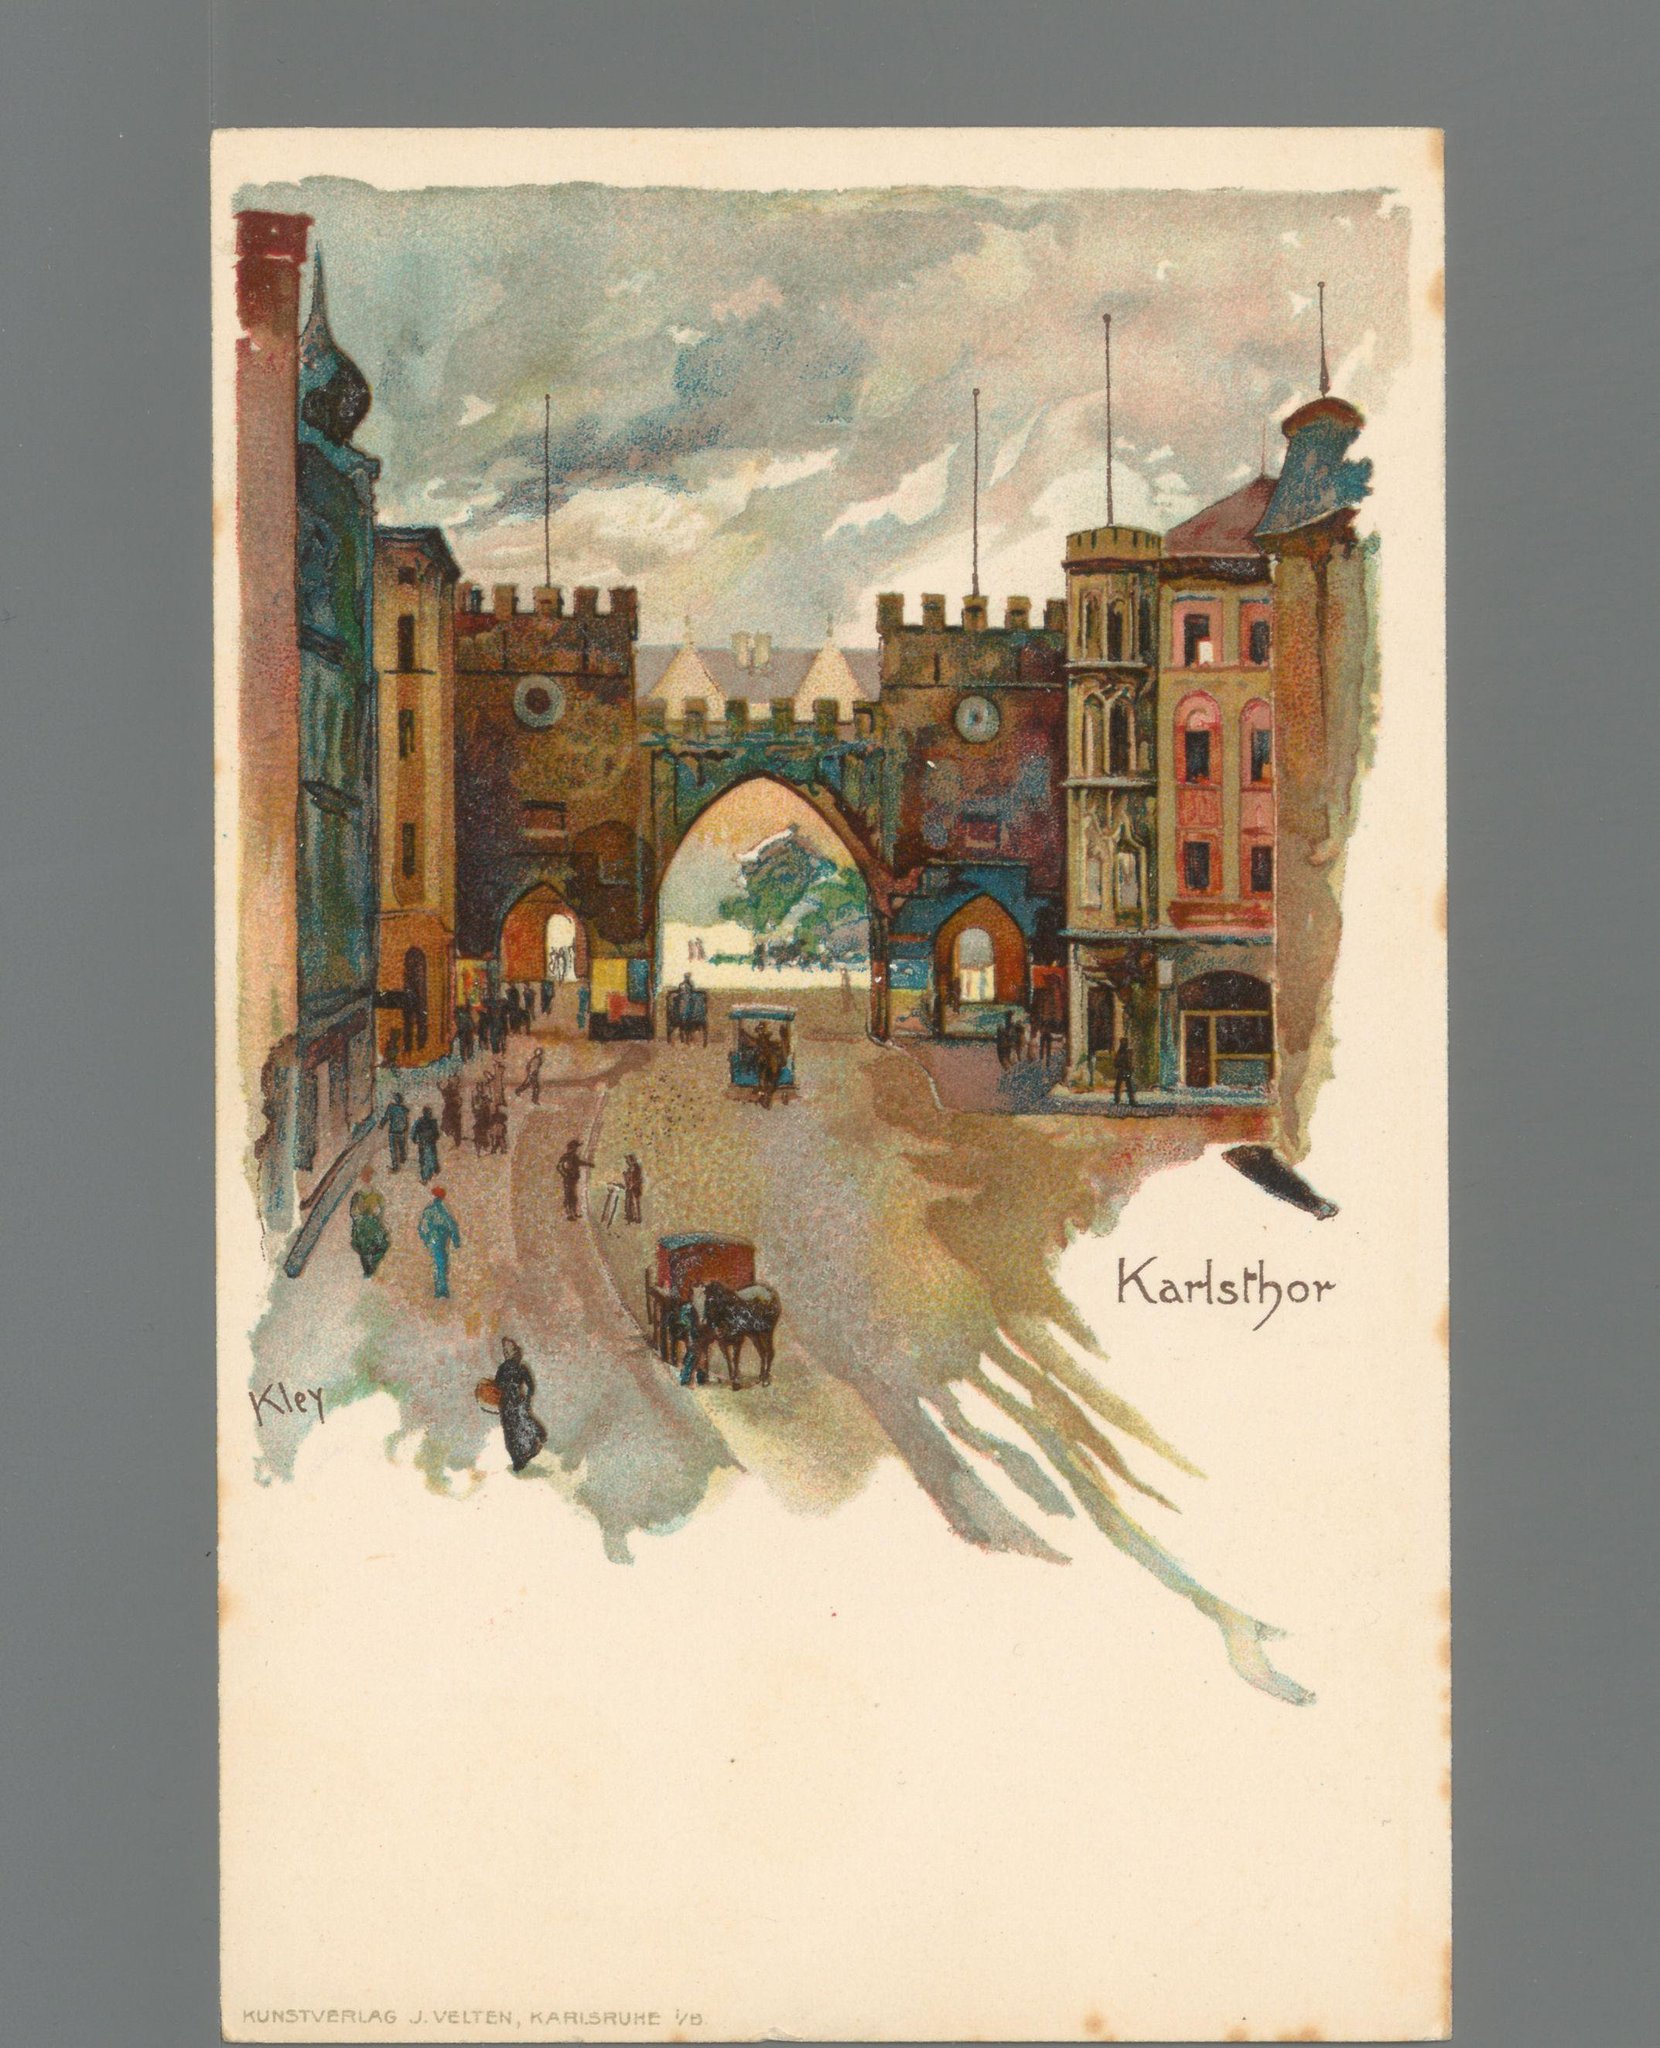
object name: ansichtkaart, prentbriefkaart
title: Karlsthor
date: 1905-1909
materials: cardboard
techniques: lithograph, writing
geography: karlsruhe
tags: city-gate